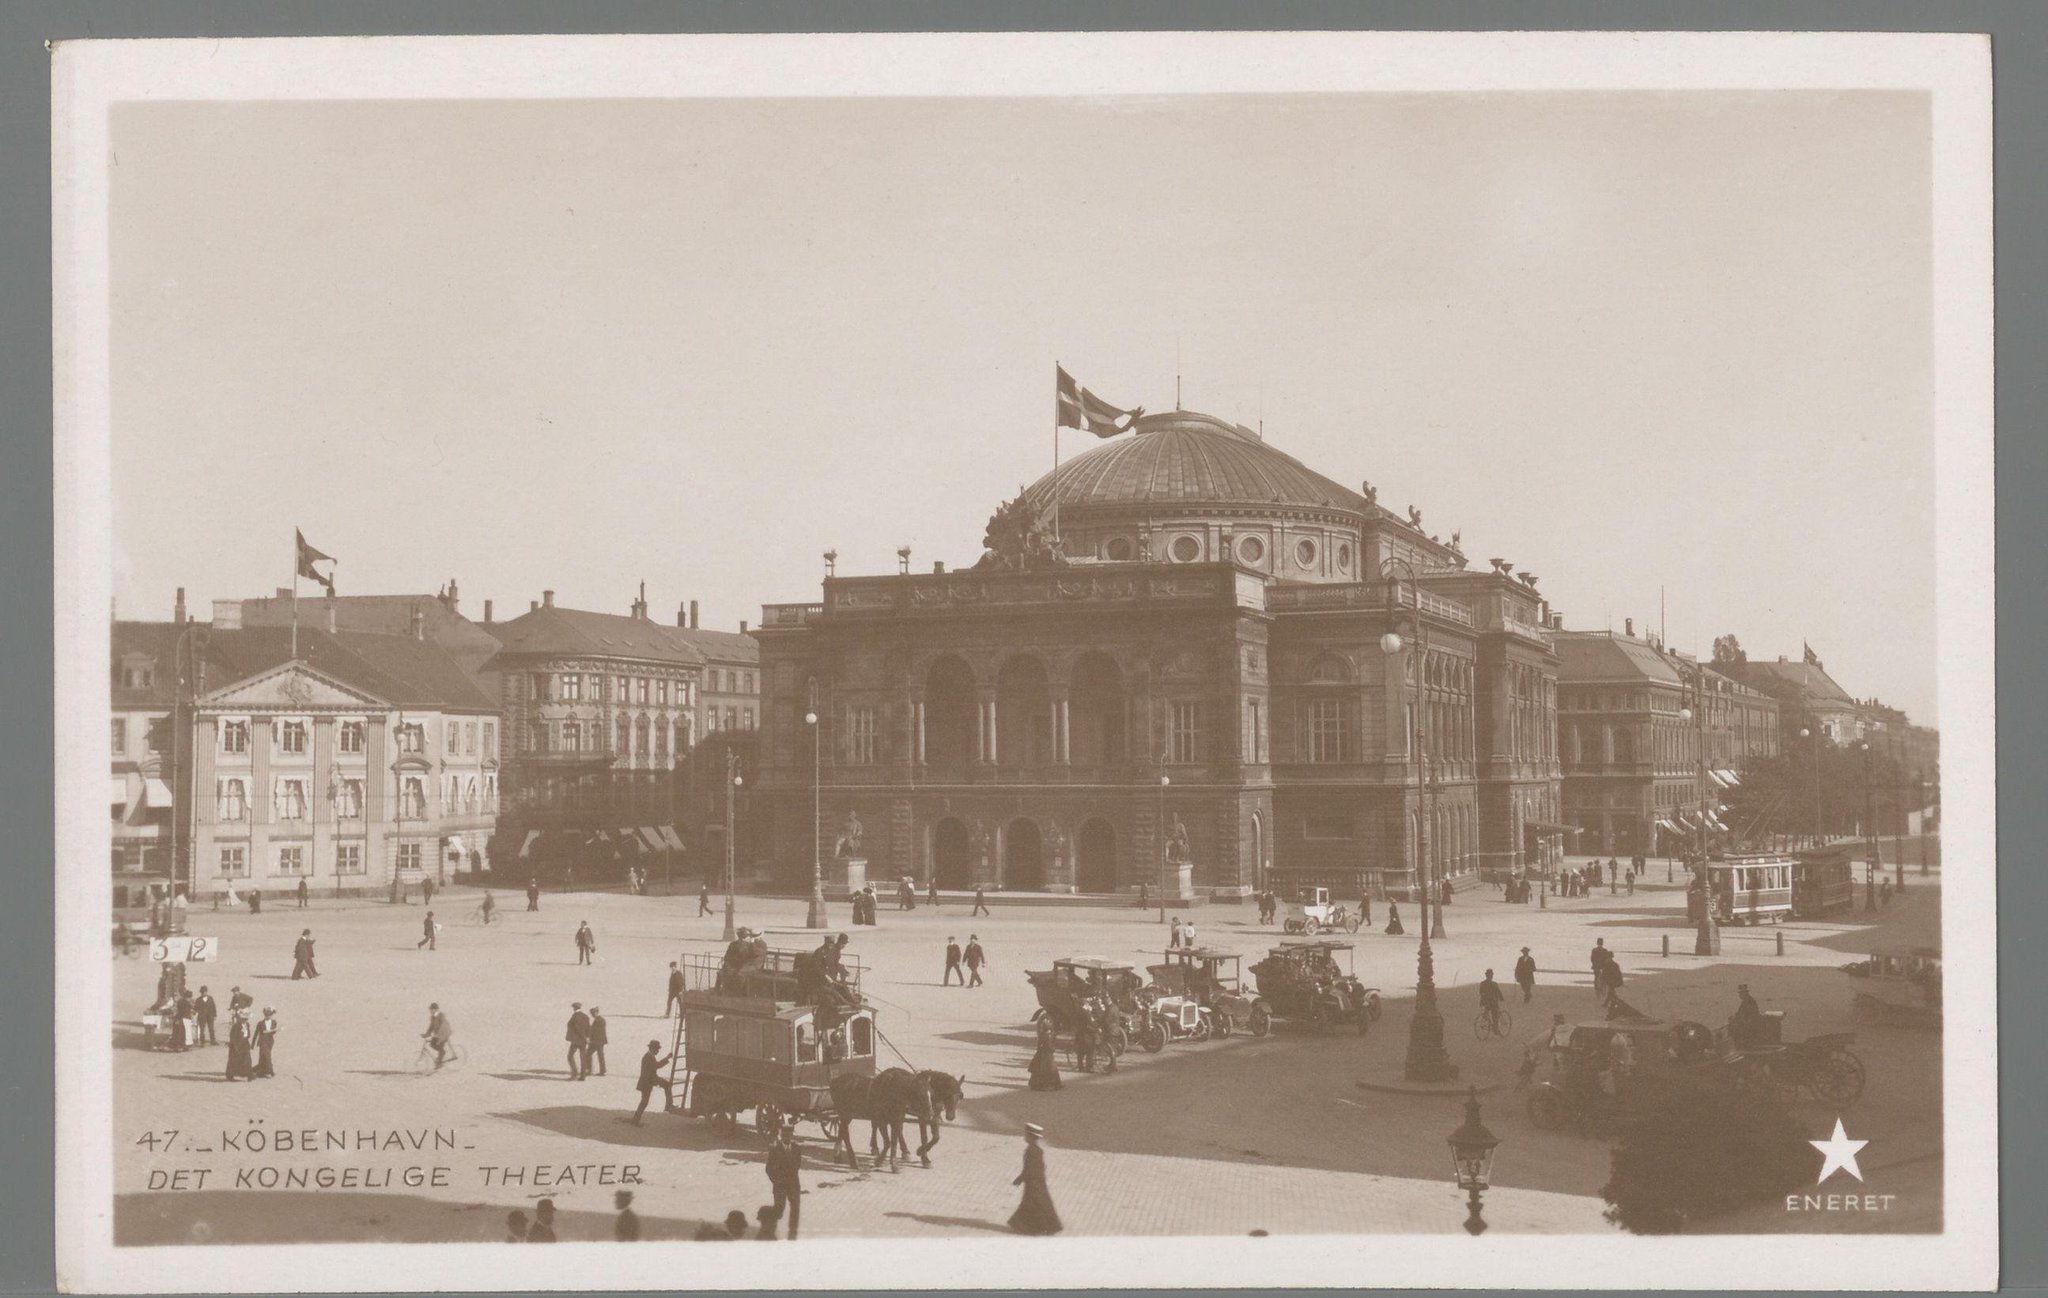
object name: photograph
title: Köbenhavn. Det Kongelige Theater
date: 1906-1920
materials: photographic support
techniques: photography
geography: copenhagen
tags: theatre (building), square, place, circus, etc. (+ city(-scape) with figures, staffage)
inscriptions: mark